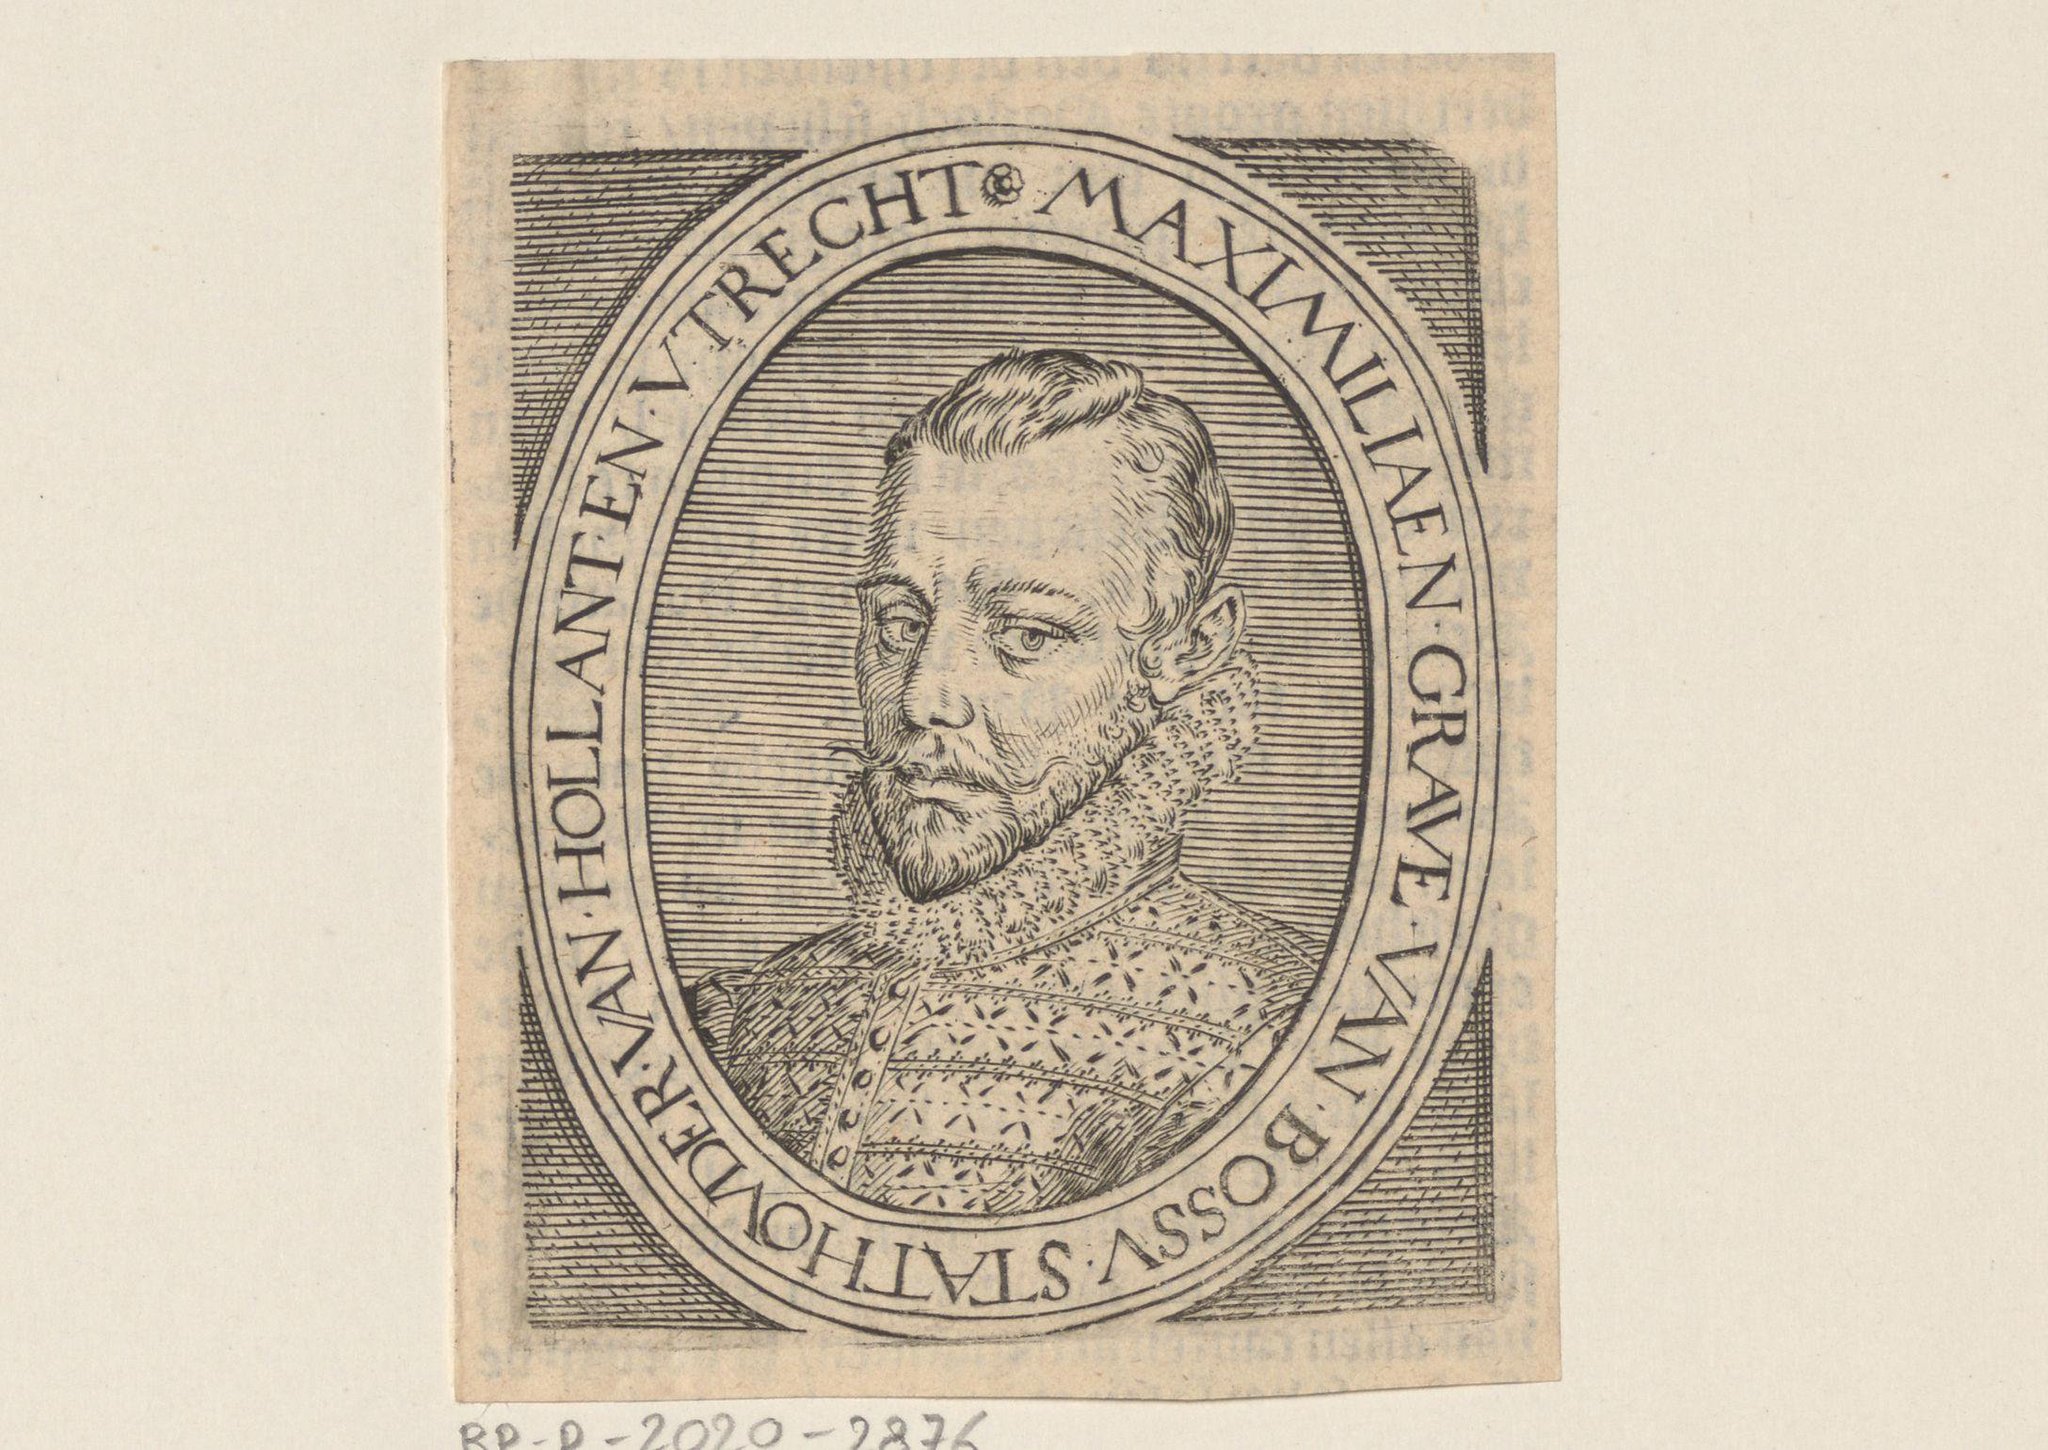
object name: print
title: Portret van Maximiliaan, graaf van Hennin-Lietard en Boussu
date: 1621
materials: paper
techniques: engraving, letterpress printing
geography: leiden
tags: antwerp, historical persons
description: Prent uit: Bor, Pieter Christiaansz. Nederlantsche oorloghen, beroerten, ende borgerlijcke oneenicheyden (...). Leiden en Amsterdam: Govert Basson en Michiel Colijn, 1621, f. 335.